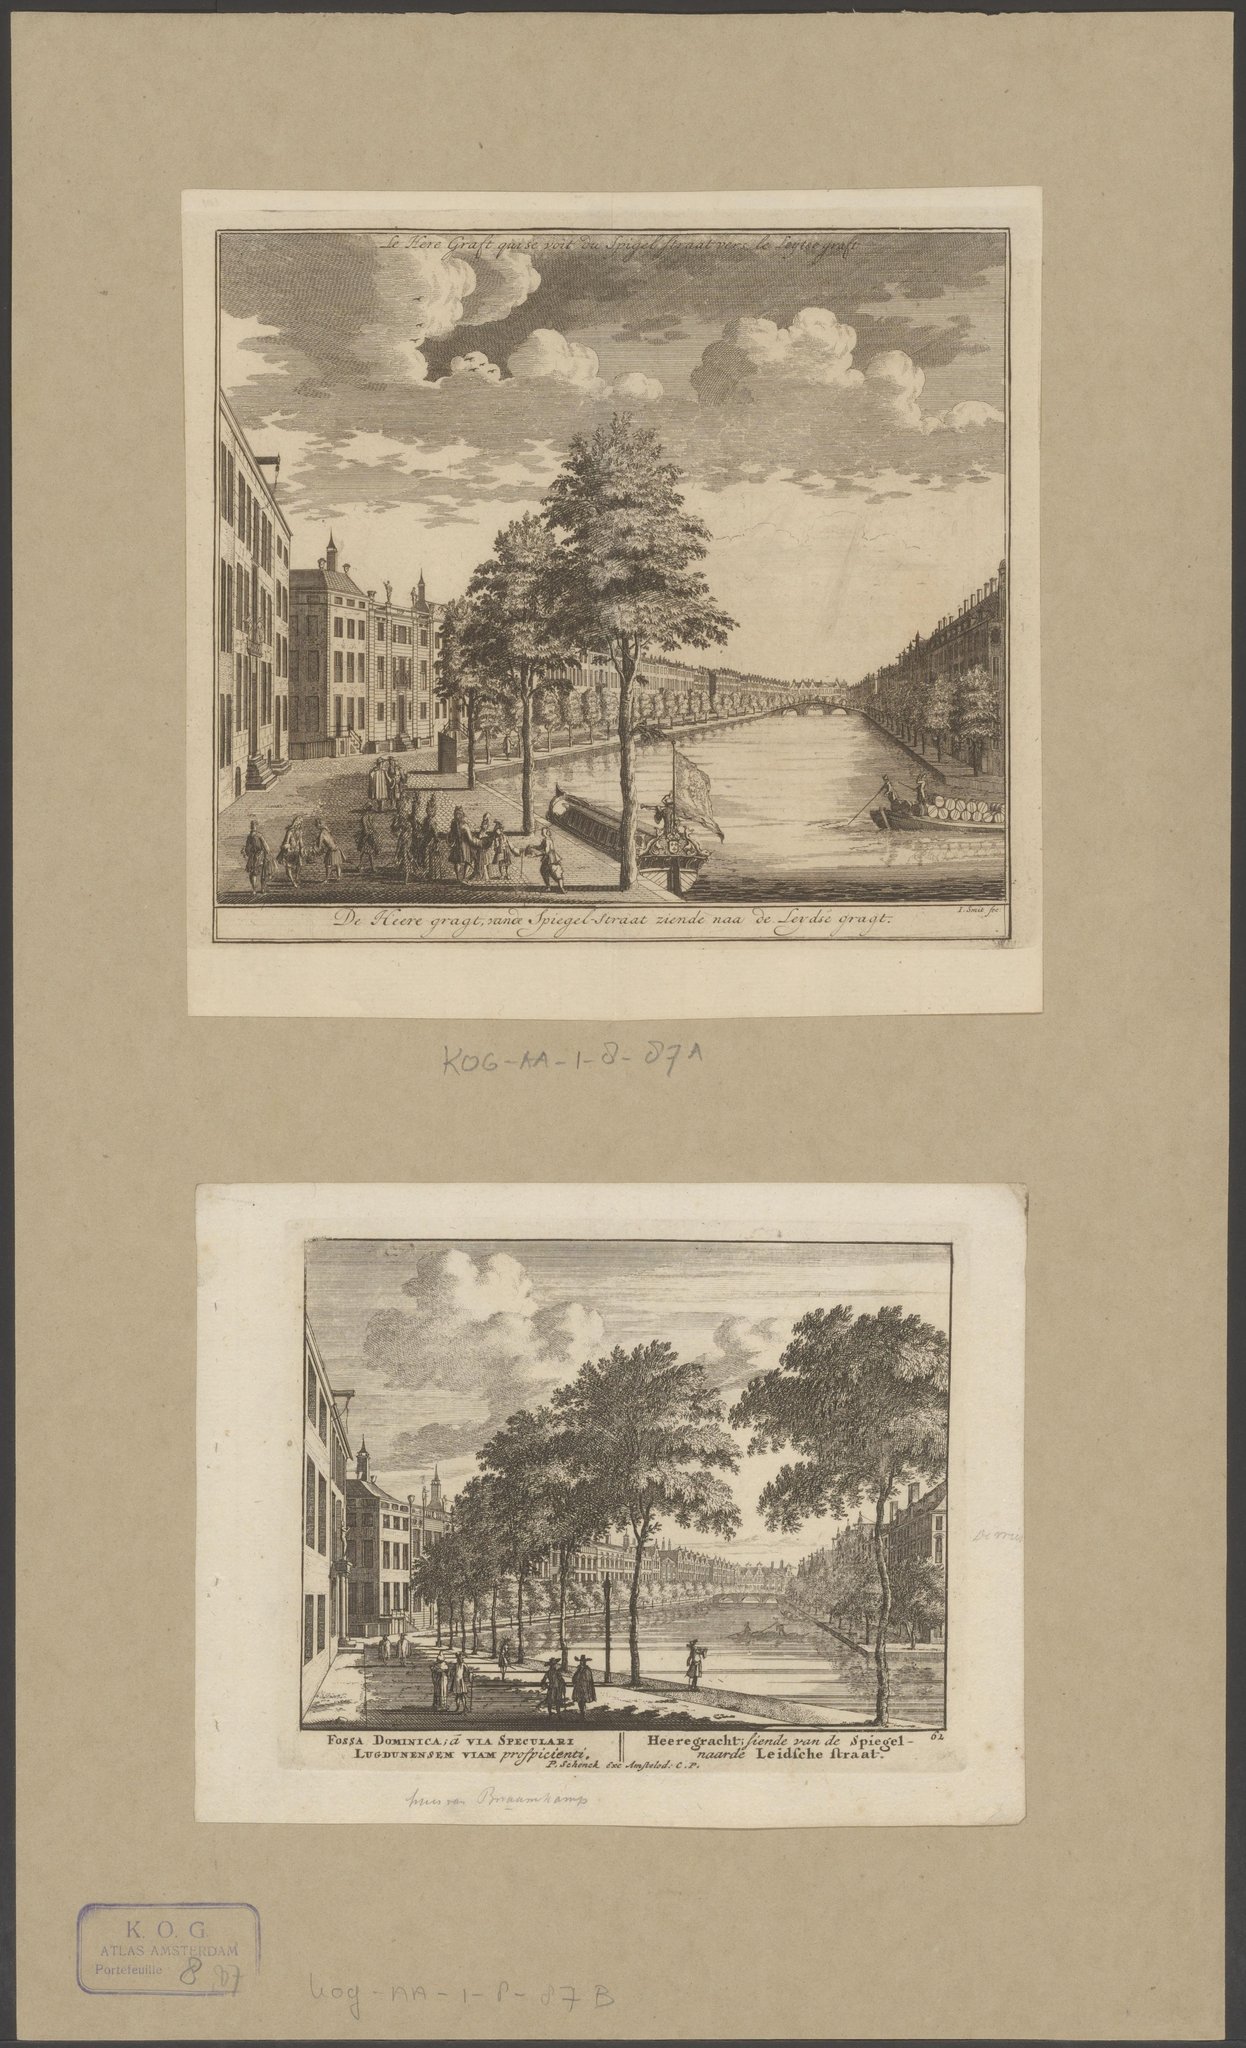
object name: print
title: Gezicht op de Herengracht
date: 1700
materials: paper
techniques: etching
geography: amsterdam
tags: city-view in general; 'veduta', canal, bridge in city across river, canal, etc., street, boat propelled by man or animal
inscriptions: collector's mark: ‘8, 87’ Lugt 1641b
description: Andere staat ook gebruikt in: Call, Jan van. Admirandorum Quadruplex Spectaculum. Amsterdam: Pieter Schenk (I), 1700. De titelprent, opdracht en het portret van Frederik van Saksen zijn gegraveerd door Pieter Schenk (I). De overige prenten uit deze serie zijn, zoals aangegeven op de titelprent, van de hand van Jan van Call (I).